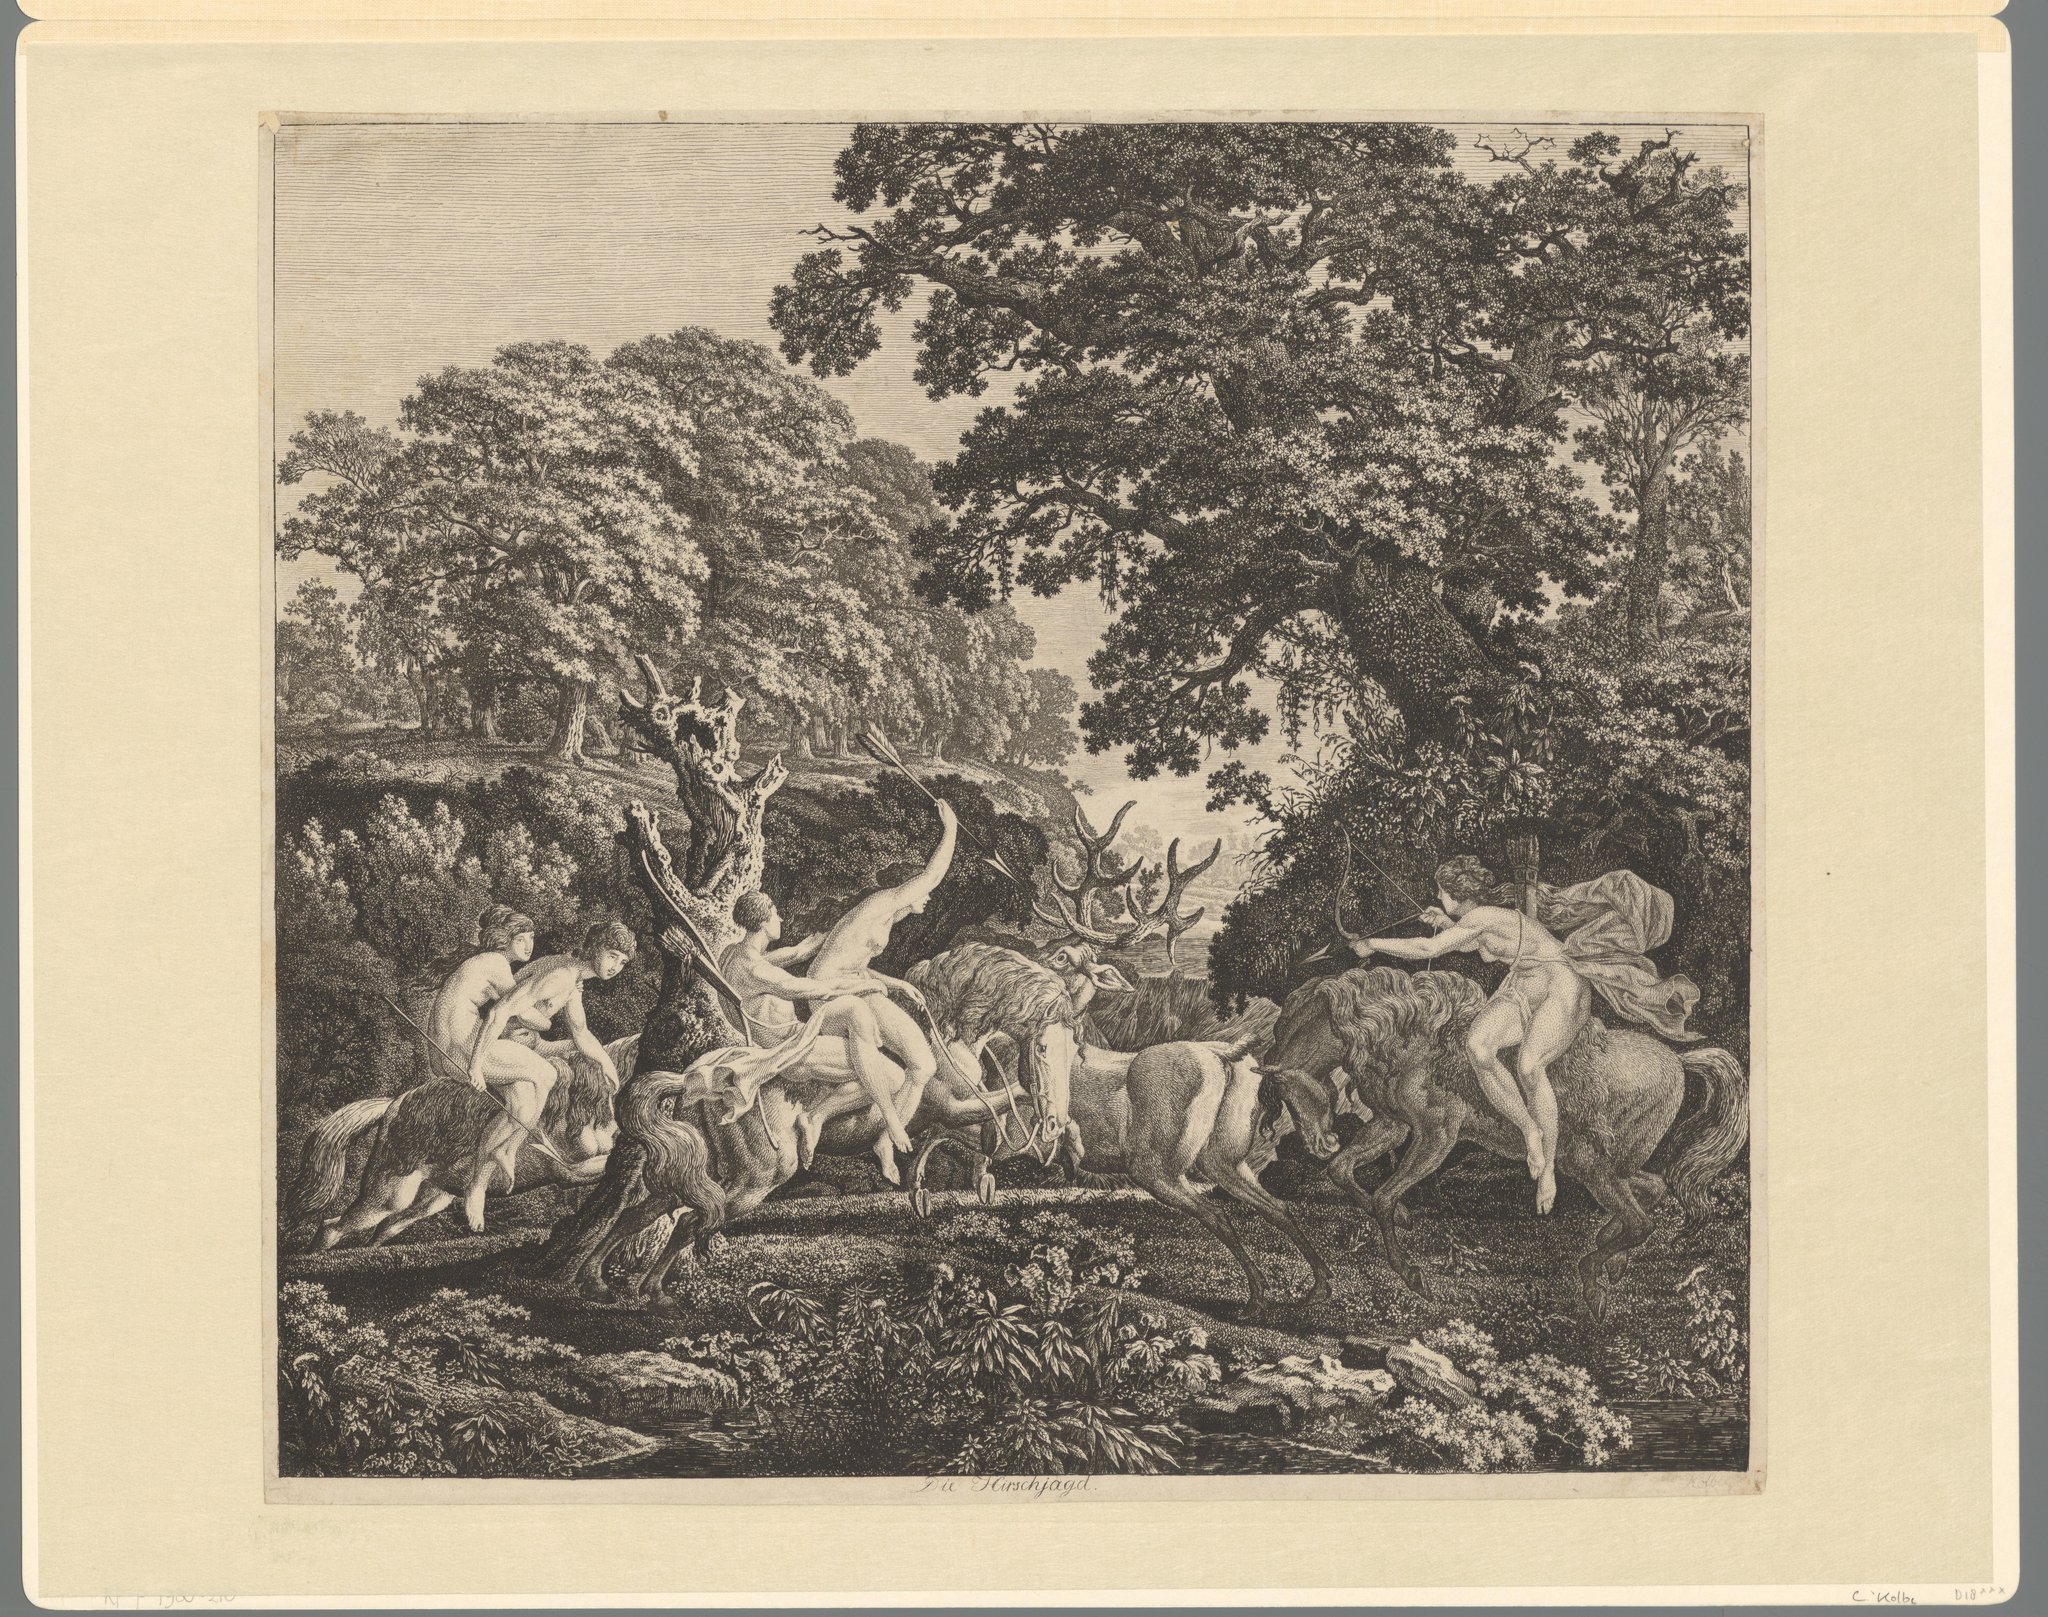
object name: print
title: Die Hirschjagd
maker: carl wilhelm kolbe (i)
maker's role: print maker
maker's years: 1757-1835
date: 1767-1797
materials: paper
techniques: etching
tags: riding a horse, ass, or mule; rider, horseman, low hill country, hoofed animals: deer (+ antlers; horn), stag-hunting, archer's weapons: arrow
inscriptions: collector's mark: Lugt 2760, collector's mark: Lugt 2228, collector's mark: Lugt 547